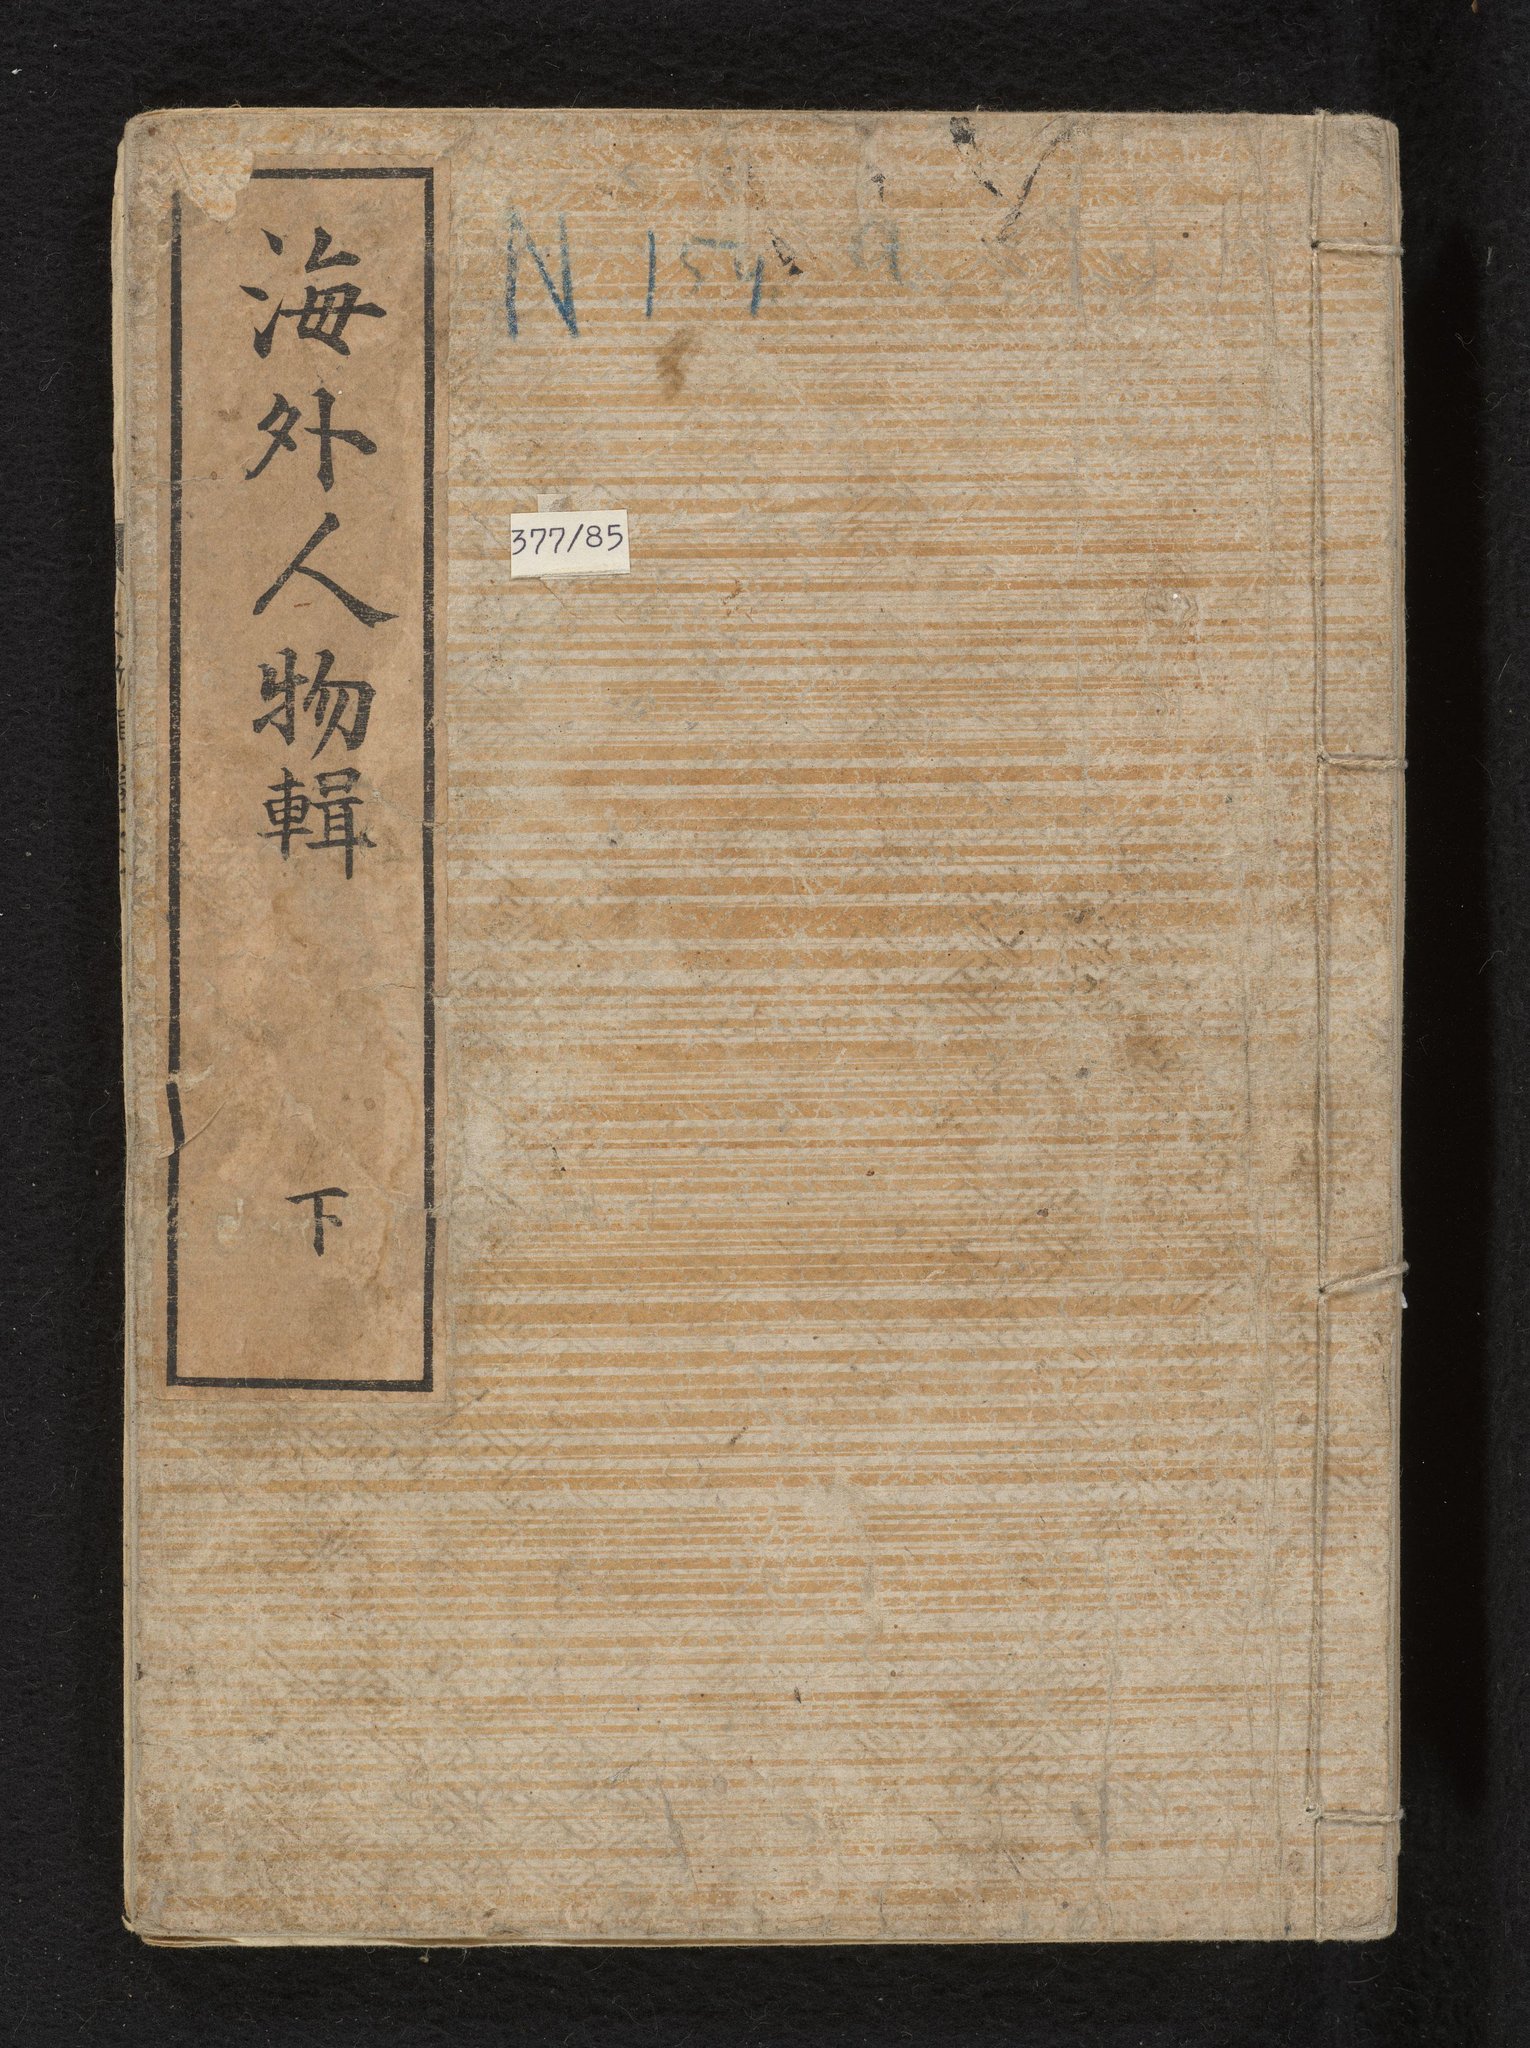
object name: book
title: Kaigai jinbutsu shu ge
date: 1854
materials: paper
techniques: woodcut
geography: japan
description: Laatste van de twee delen. Met achtereenvolgens de inwoners van (waarschijnlijk): Turkije, Makassar, de Banda eilanden, Afrika, ? mogelijk fonetisch 'Kaffers', Guinea, Mauritanië, Moskou, ?, Denemarken, Hongarije, Polen, Italië, Duitsland, Frankrijk, Nederland, Engeland, Argentinië, Canada, Costa Rica, ?, Samojeden, Vuurland.